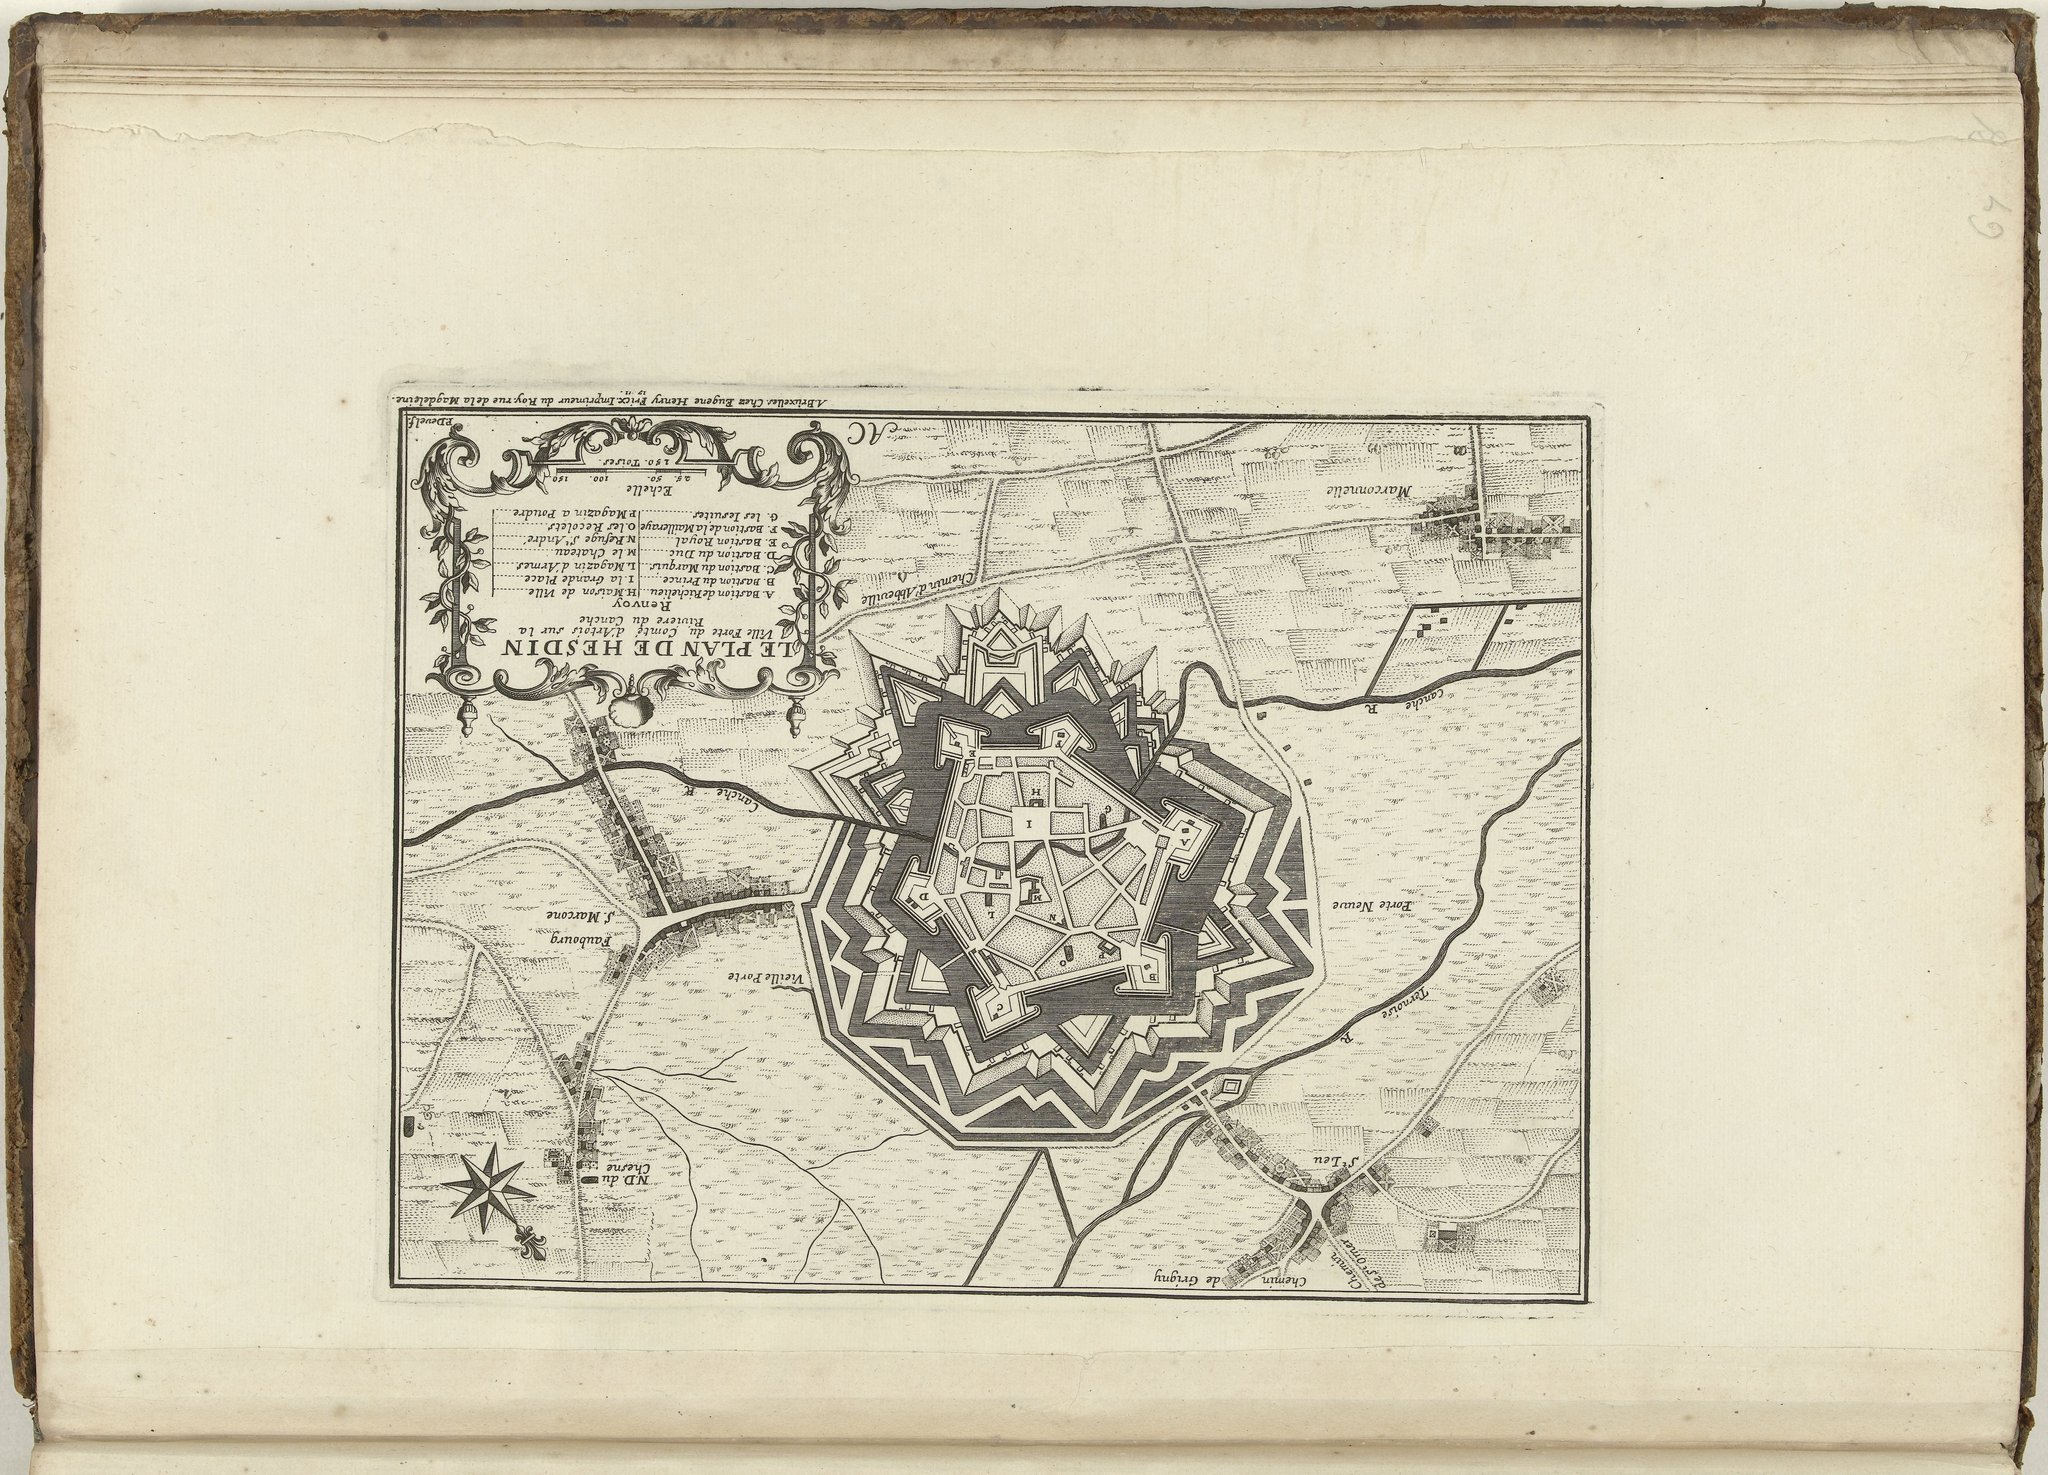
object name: map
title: Le Plan de Hesdin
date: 1711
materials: paper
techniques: engraving, etching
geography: brussels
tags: maps of cities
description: Plattegrond van Hesdin, 1711. Rechtsonder de legenda A-P. Onderdeel van een gebundelde verzameling van plannen van veldslagen en steden vermaard in de Spaanse Successieoorlog.